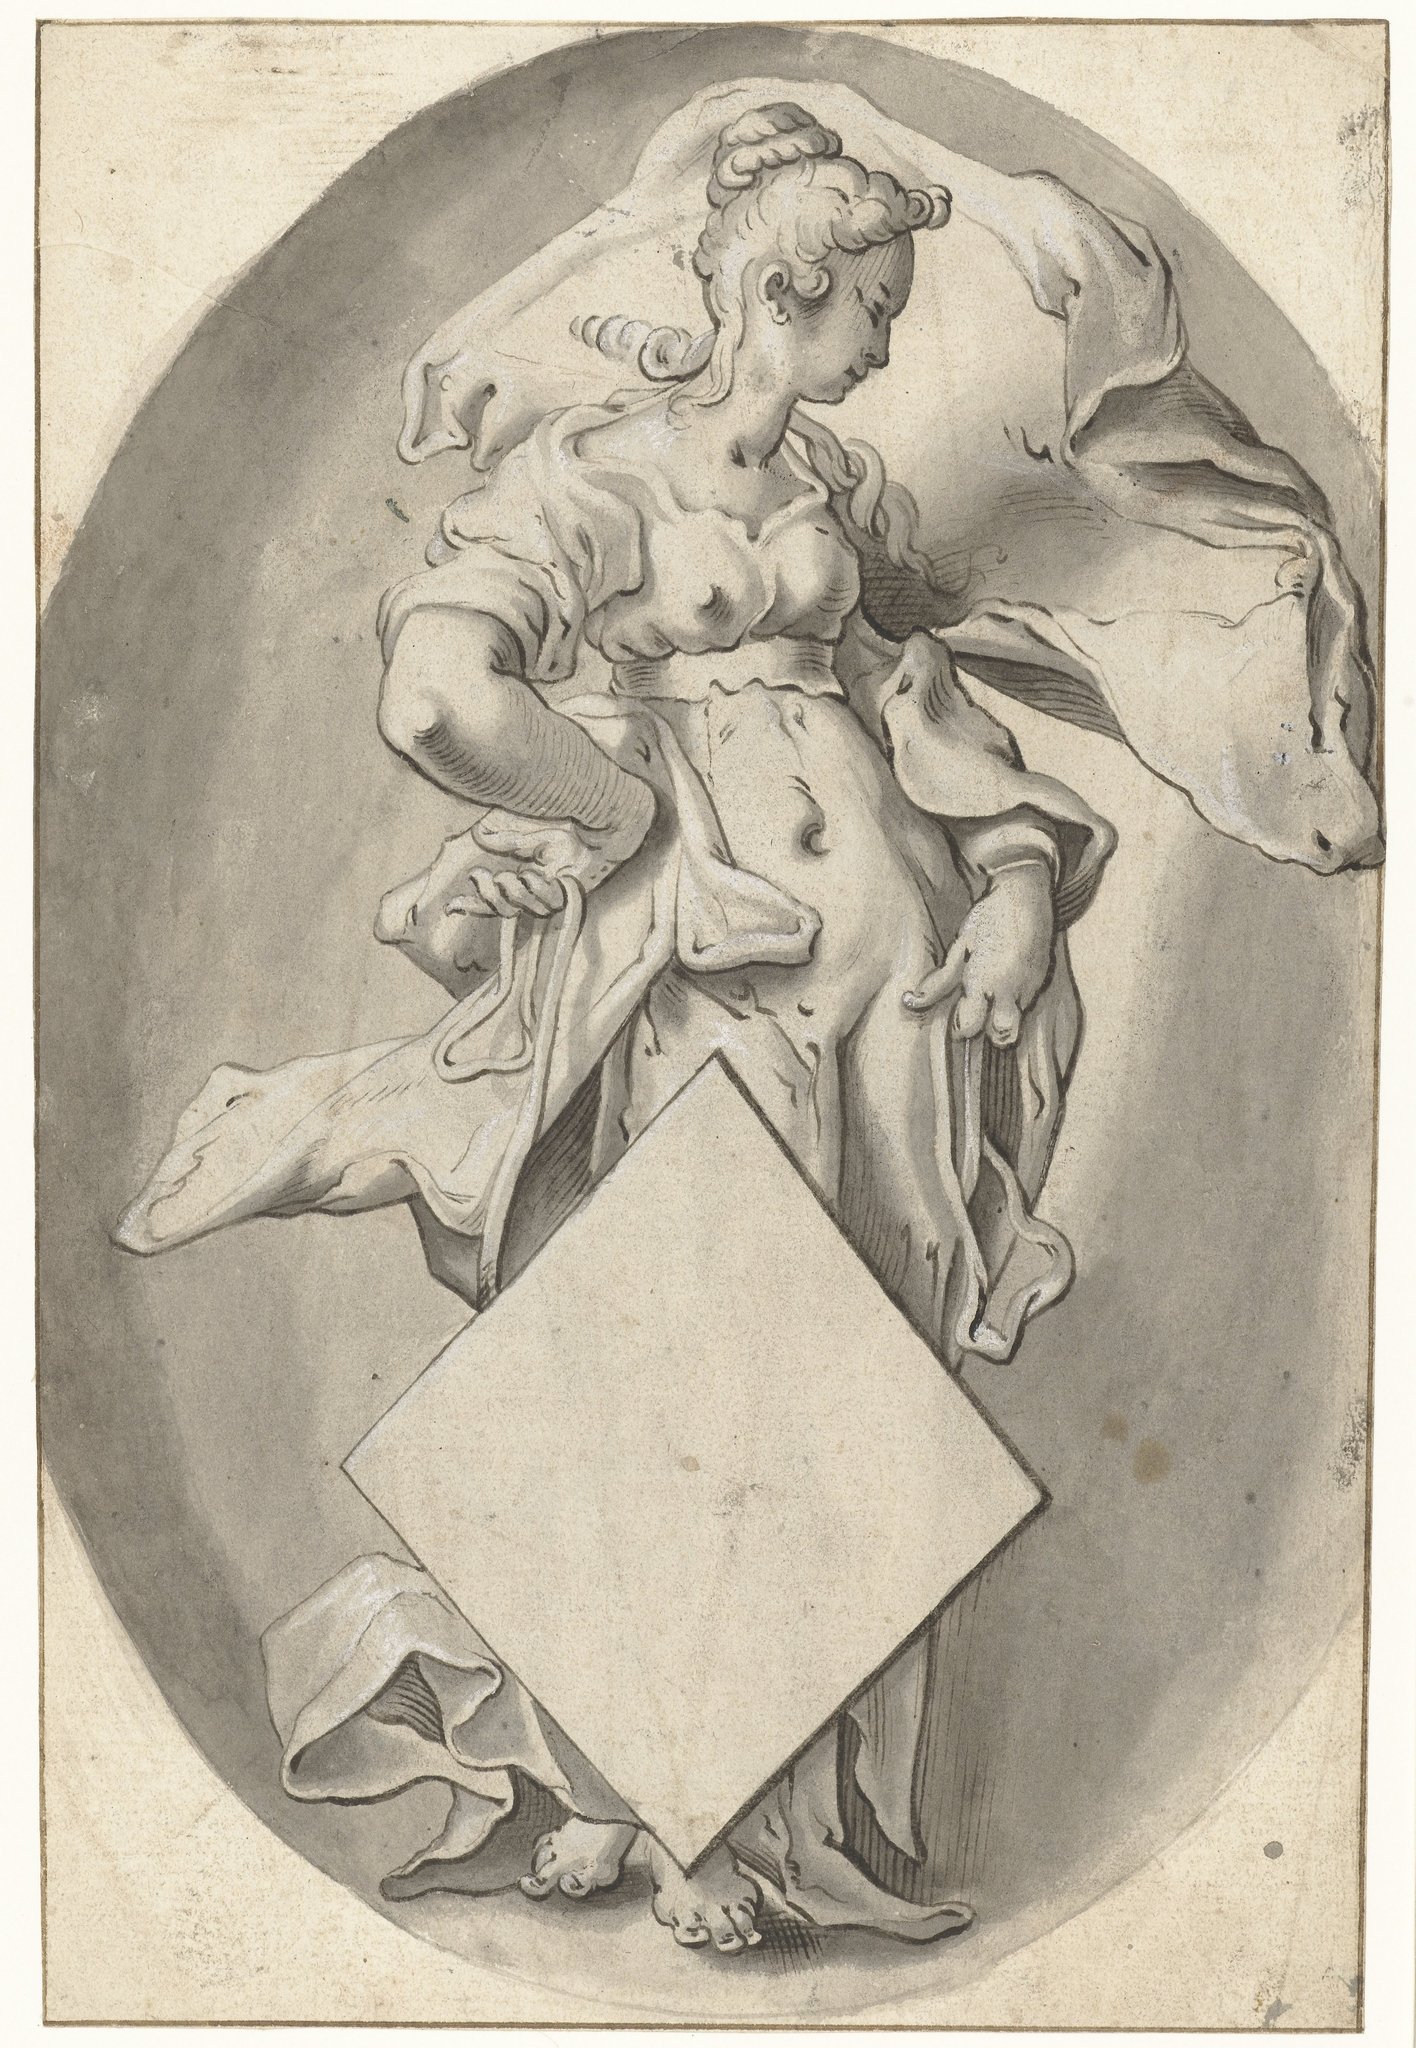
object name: drawing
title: Vrouwelijke schildhouder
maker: joachim wtewael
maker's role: draughtsman, painter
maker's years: 1566-1638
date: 1576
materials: ink, paint, paper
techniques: brush, pen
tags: protective weapons: shield, hand on the hip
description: Vrouwelijke schildhouder in een ovale nis, naar links gekeerd, met een hand op haar heup. In elke hand houdt ze een lint vast dat vastzit aan een diamantvormig schild.